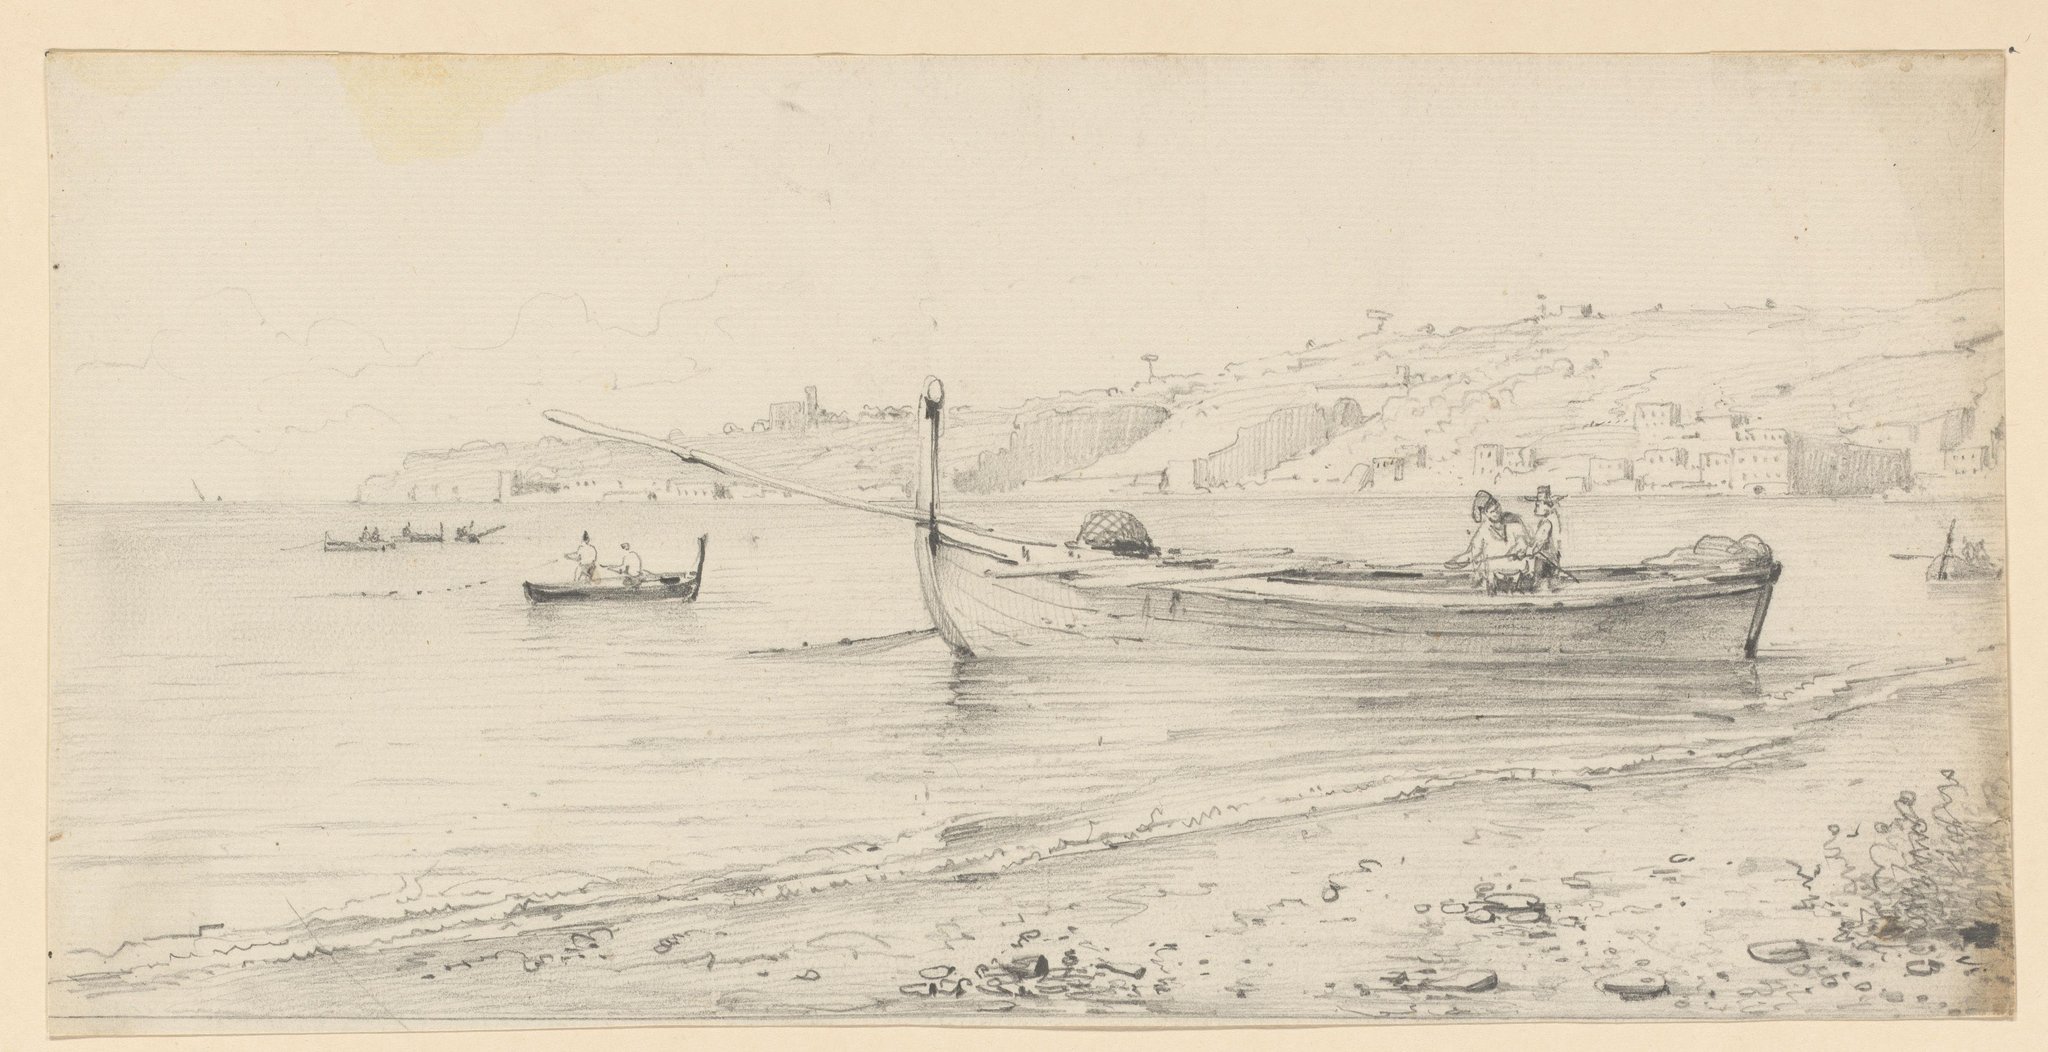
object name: drawing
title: Kustlandschap met vissersboten die netten binnenhalen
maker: willem anthonie van deventer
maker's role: draughtsman, painter, print maker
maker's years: 1824-1893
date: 1834-1893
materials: paper, pencil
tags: coast, sea and coastal fishery